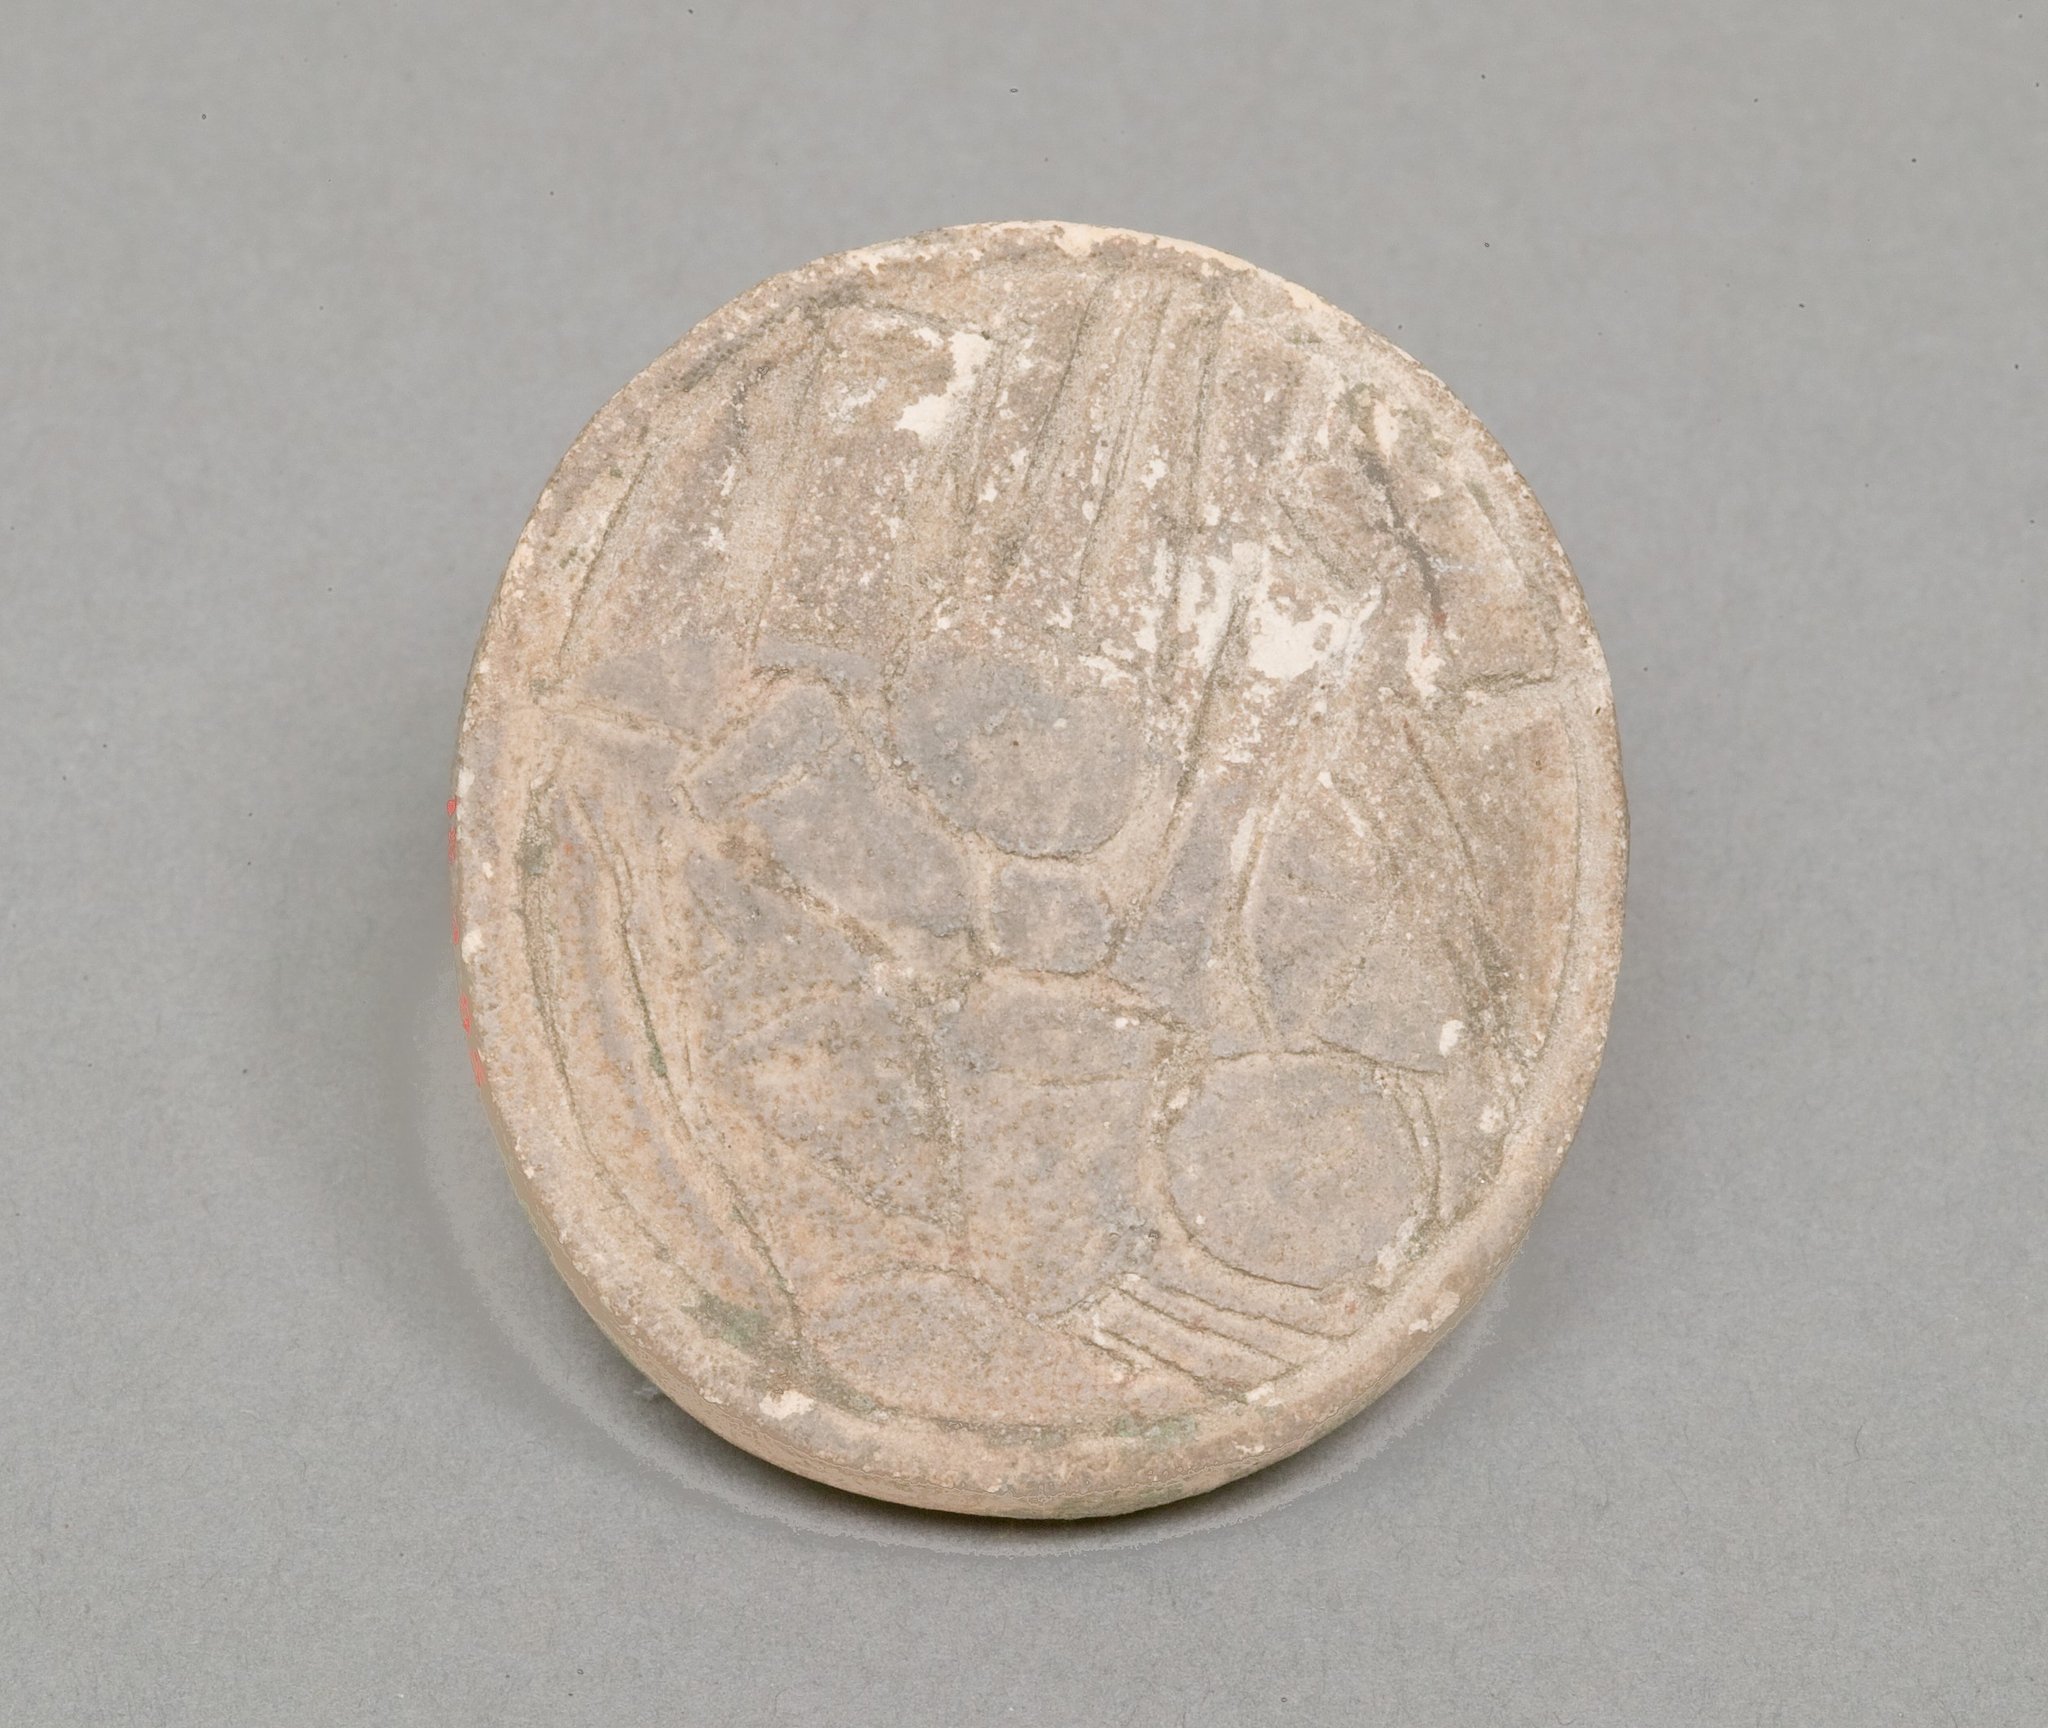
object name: model dish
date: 1850-1800 BCE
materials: limestone, paint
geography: egypt